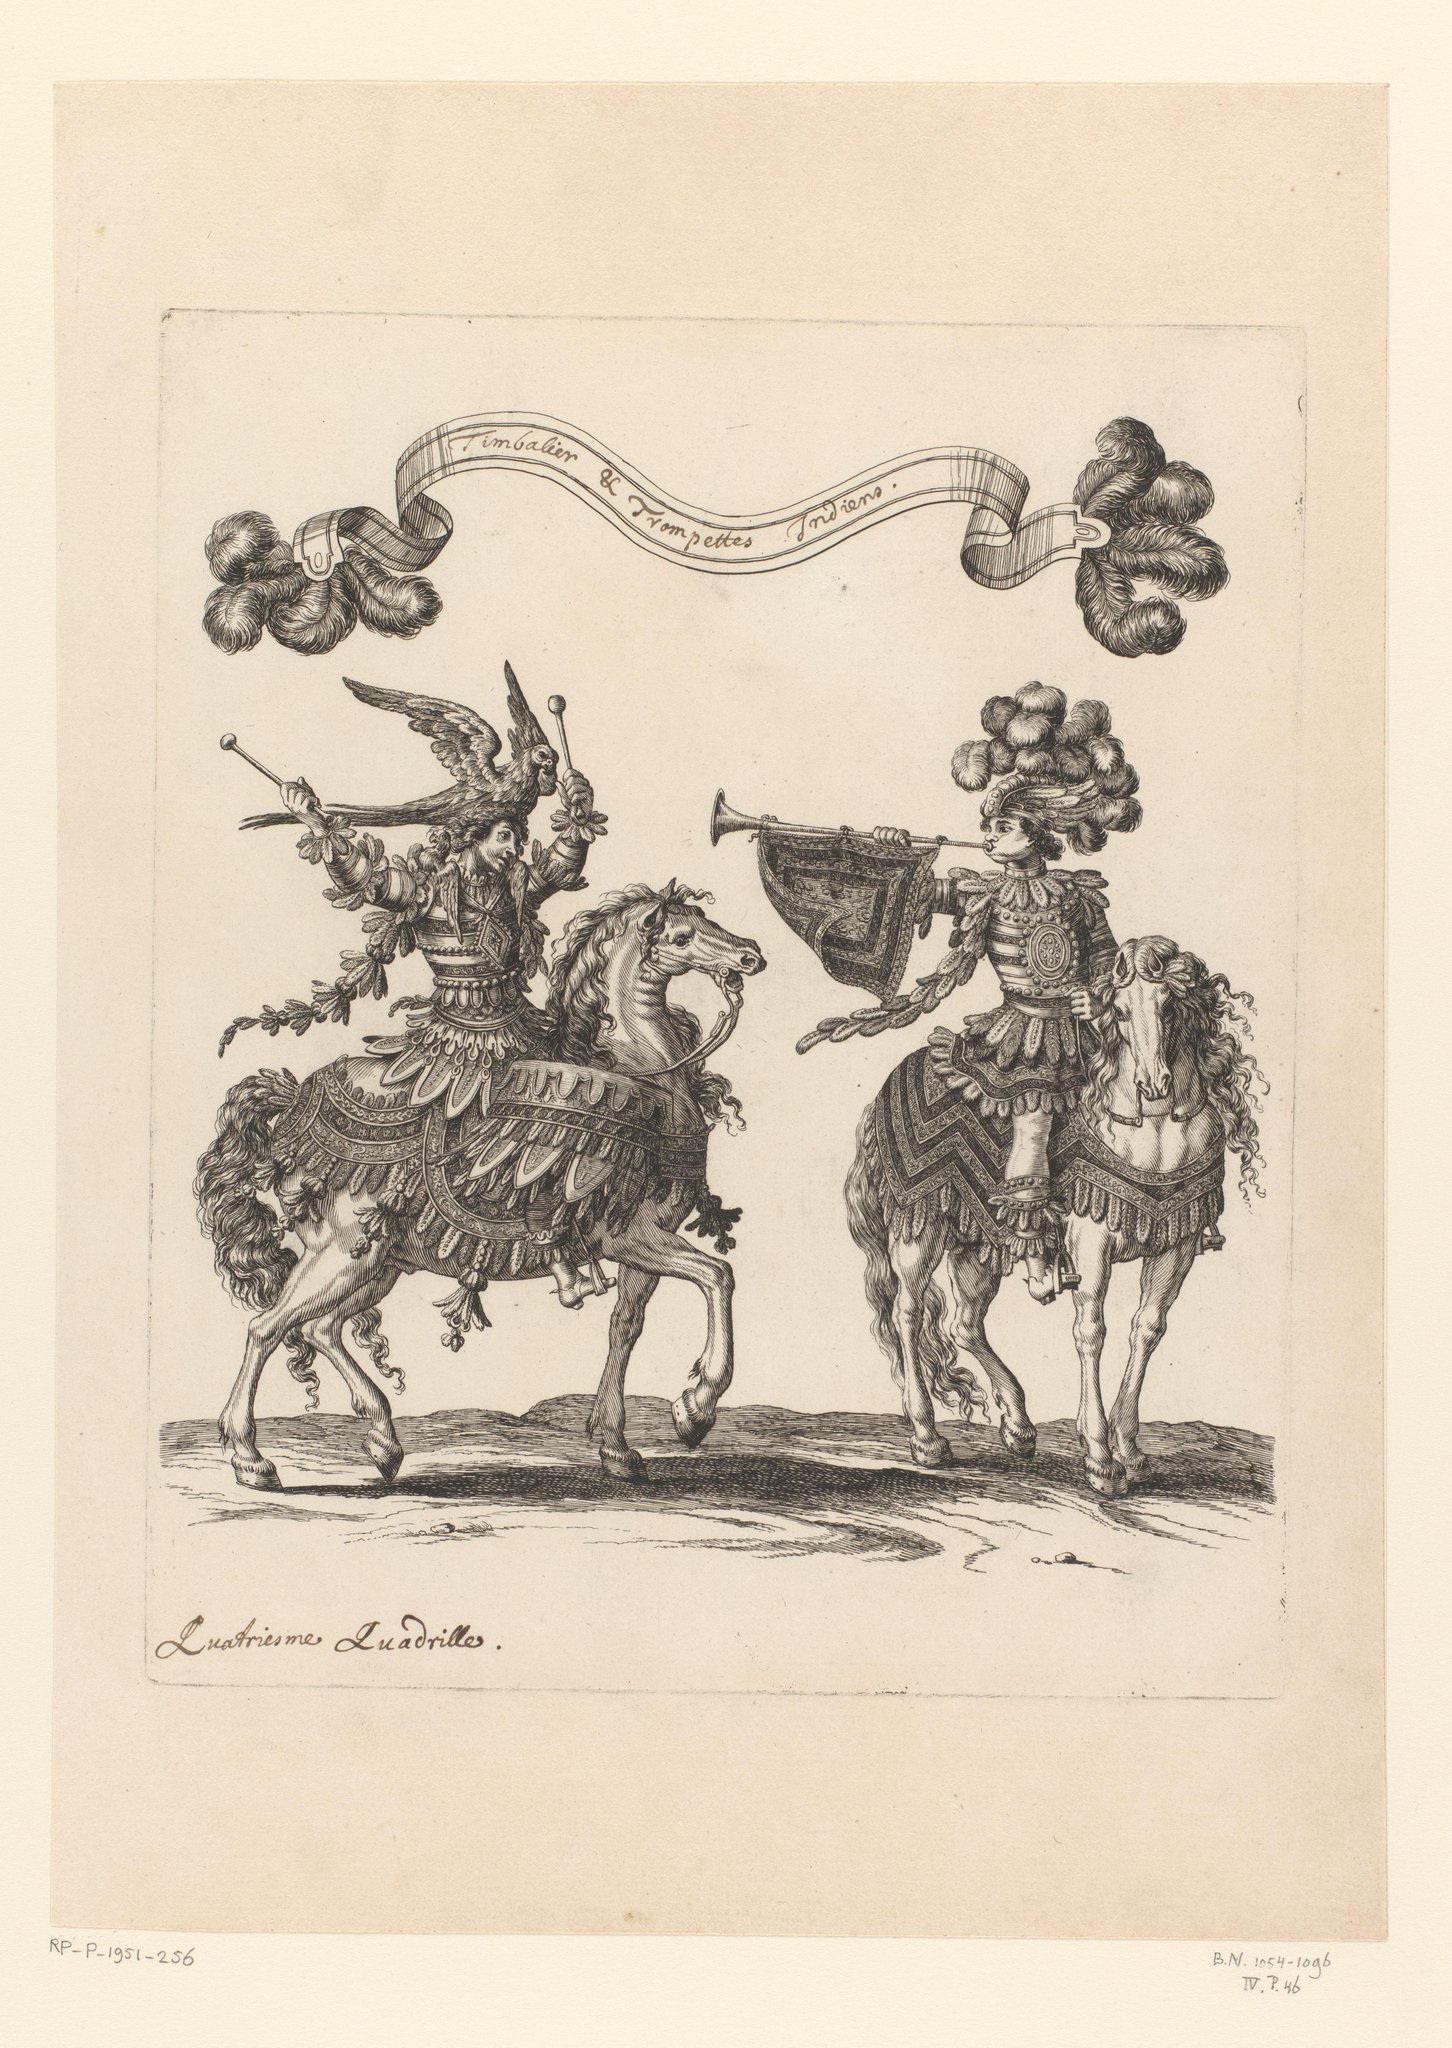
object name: book illustration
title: Trommelslager en trompettist te paard verkleed als Indianen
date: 1670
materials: paper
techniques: etching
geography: france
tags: dress-up party, horn, trumpet, cornet, trombone, tuba, indigenous peoples of north america (+ costume), tournament, drum-head court-martial, horse, clothes, costume, festivities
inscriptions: collector's mark: Lugt 2228, inscription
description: Prent uit: Perrault, Charles. Courses de testes et de bague faites par le Roy et par les princes et seigneurs de sa cour en l'année M.DC.LXII. Parijs: Imprimerie Royale, 1670. De prenten illustreren de door Lodewijk XIV georganiseerde festiviteiten in juni 1662 te Tuileries, zoals steekspelen met figuren in verschillende kostuums.